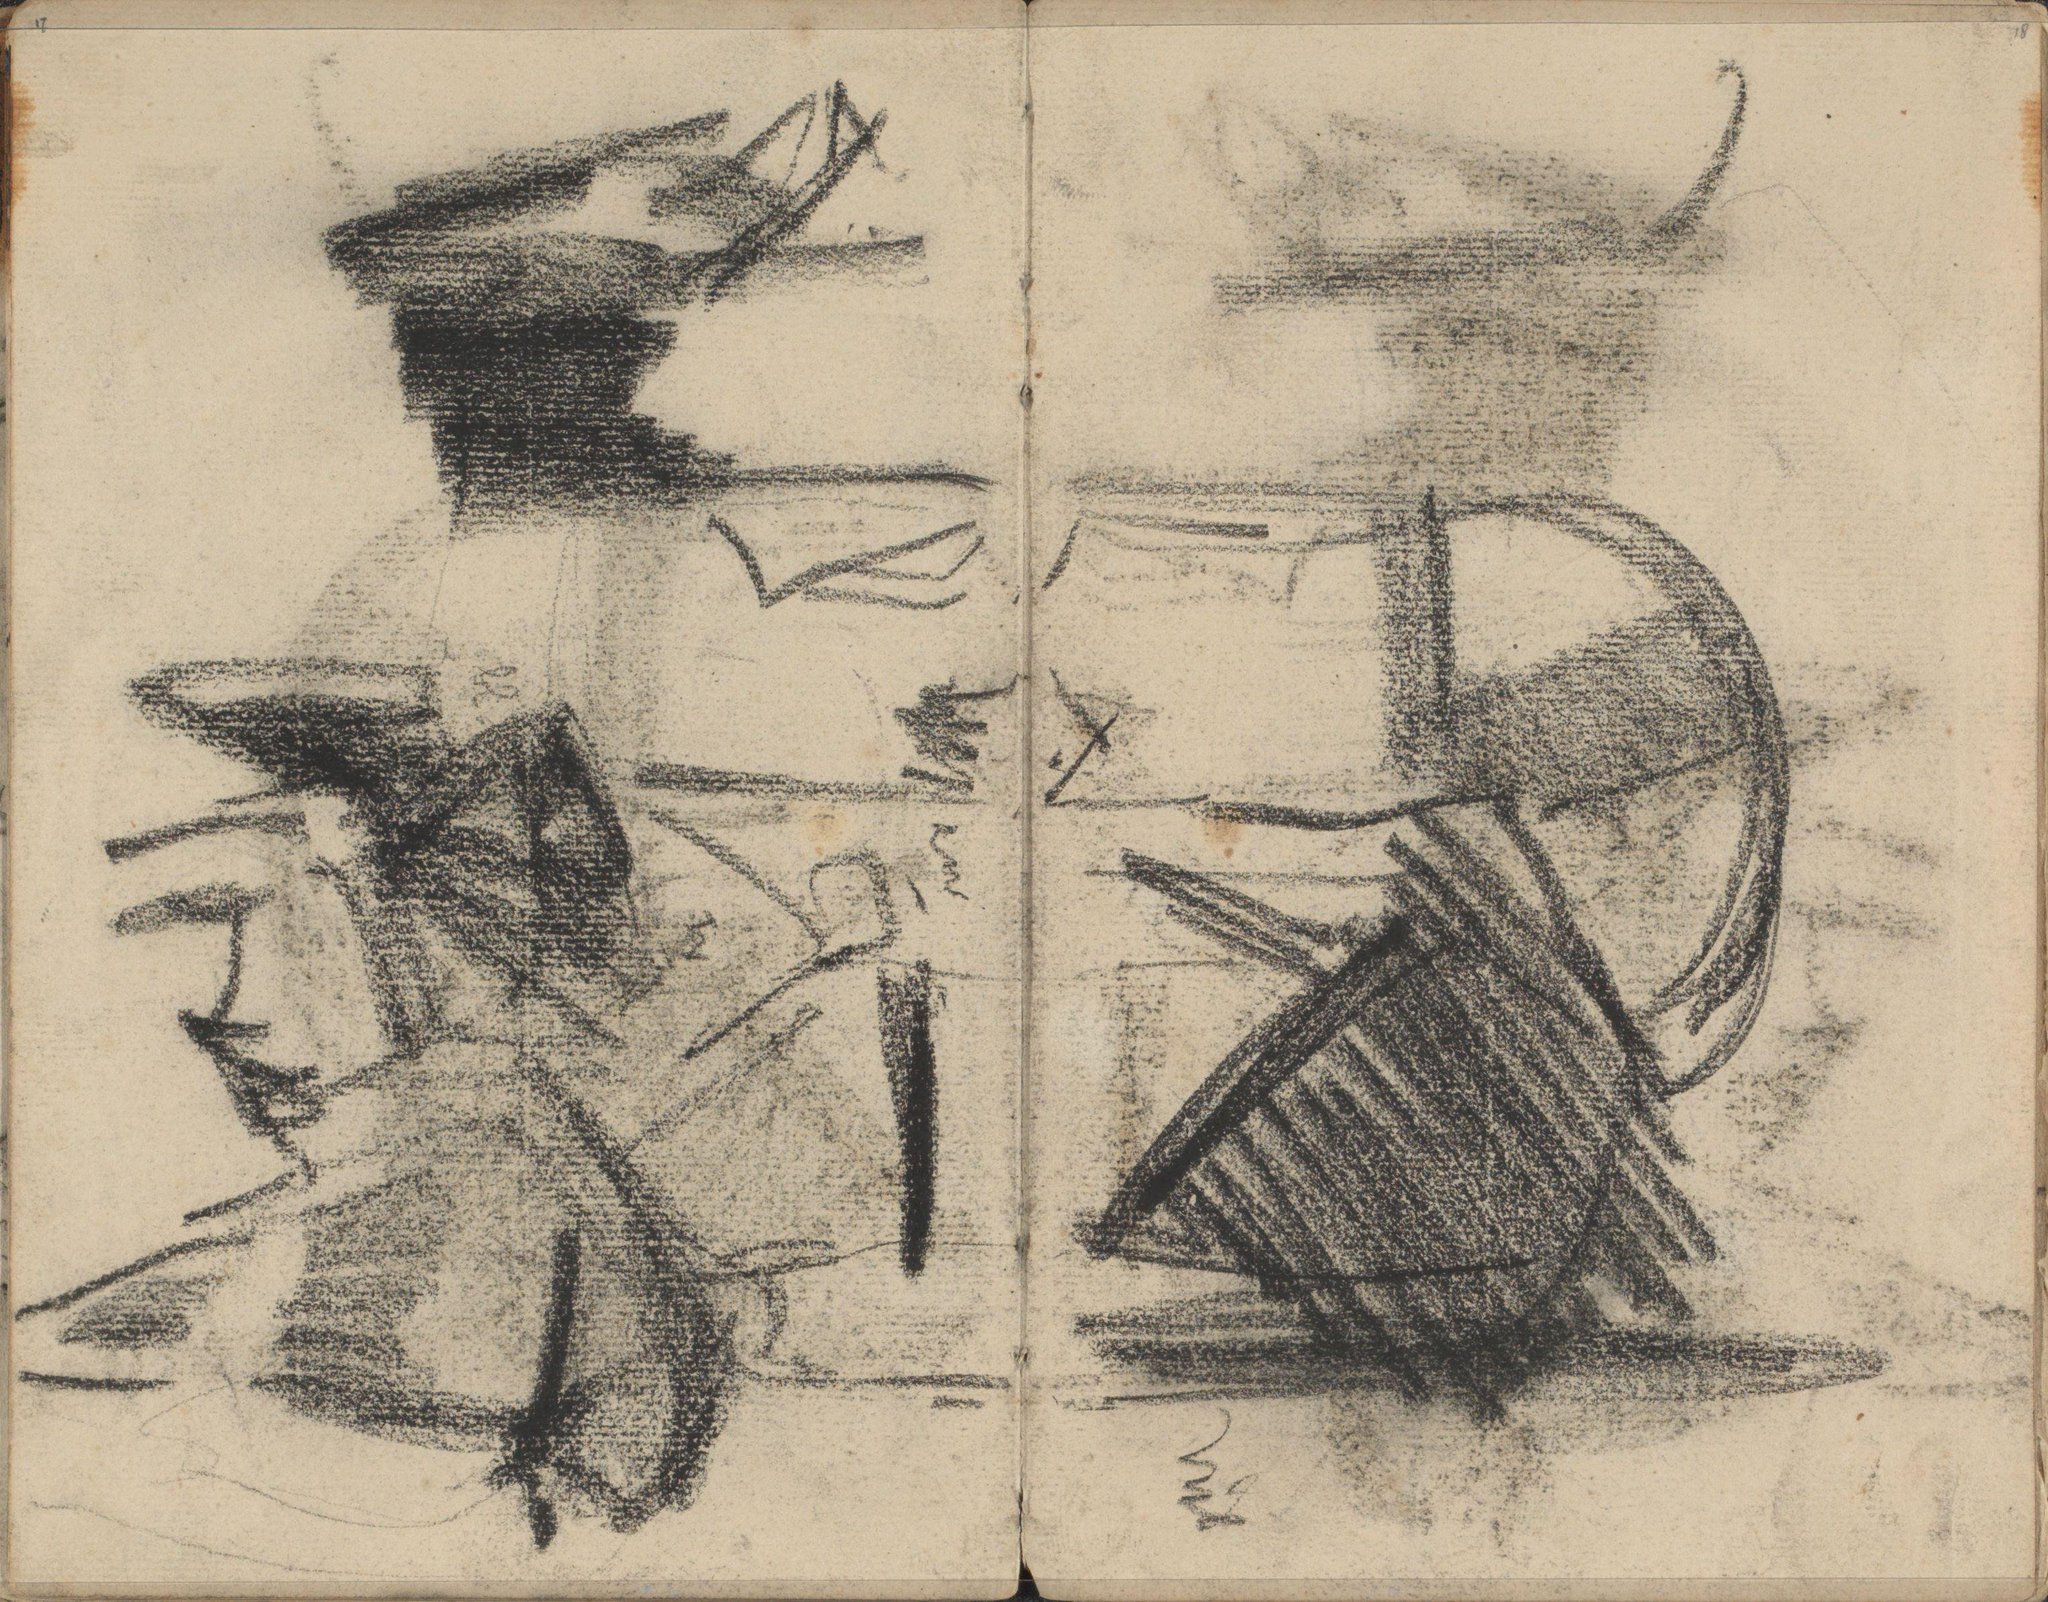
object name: sketchbook leaf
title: Studie, mogelijk van een paard bij een poort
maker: george hendrik breitner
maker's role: draughtsman, painter, print maker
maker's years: 1857-1923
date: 1887-1891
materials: chalk, paper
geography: amsterdam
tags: gate, entrance, horse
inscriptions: kleurnotitie, handgeschreven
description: Pagina 17 en pagina 18 uit een schetsboek met 17 bladen.